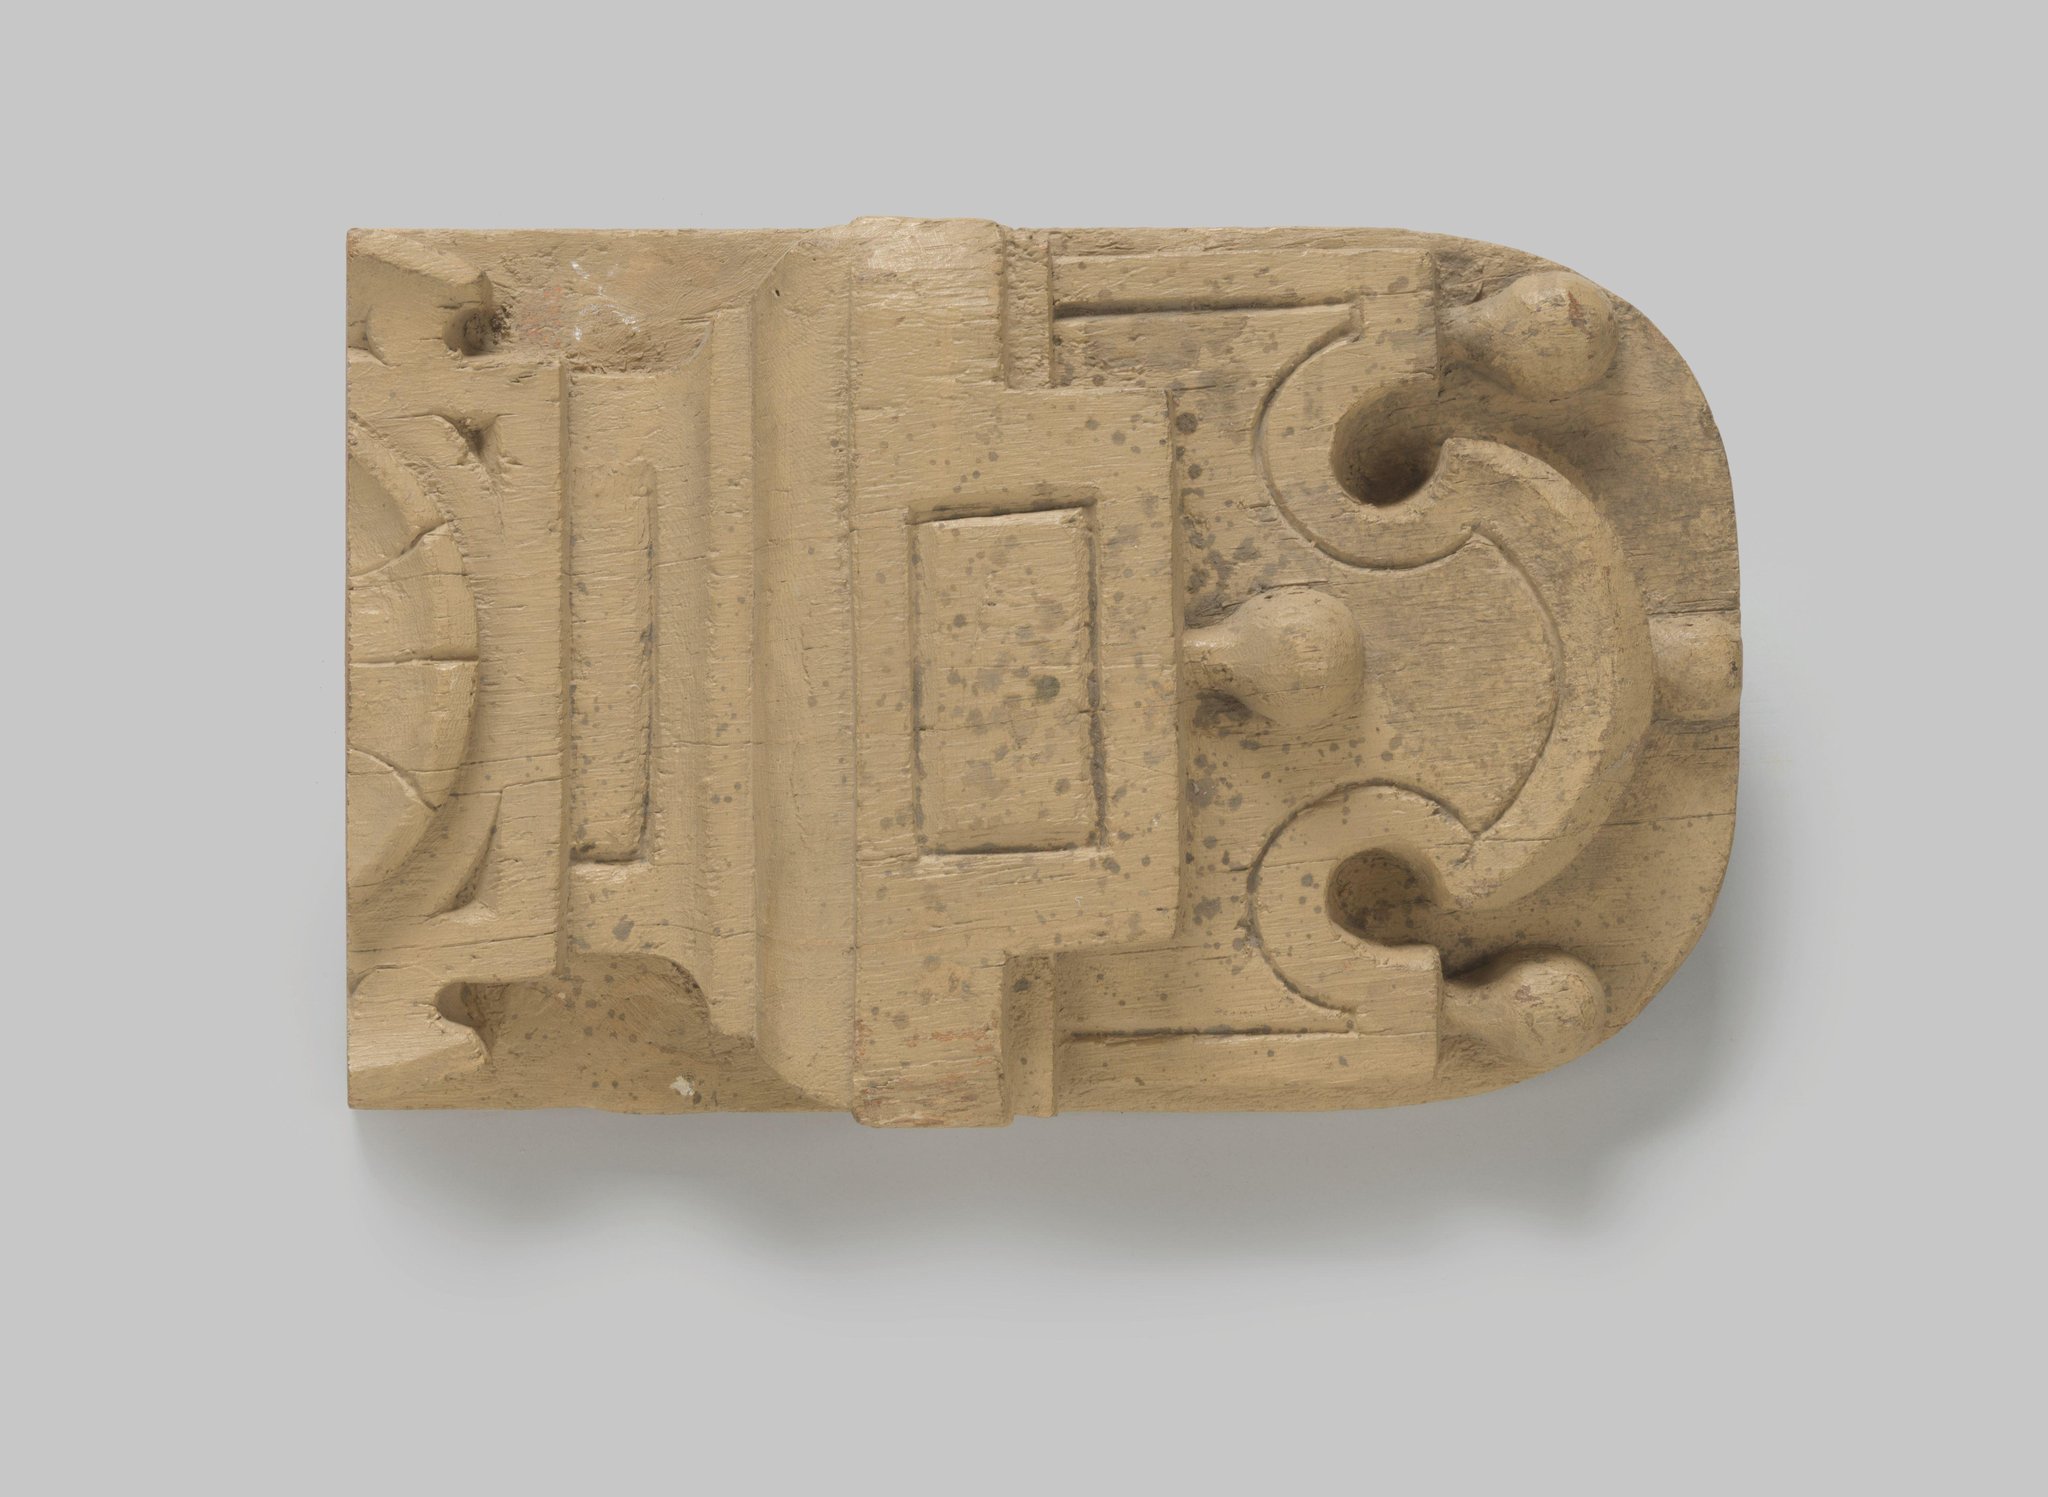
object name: stile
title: Gedeelte van een gebeeldhouwde stijl van eikenhout, afkomstig uit het z.g. Huis van Alva, Warmoestraat te Amsterdam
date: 1500-1699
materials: wood, paint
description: Gedeelte van gebeeldhouwde eikenhouten stijl (behorend bij BK-KOG-754-6), afkomstig uit het z.g. Huis van Alva, Warmoestraat te Amsterdam. In totaal gaat het om zes beschilderde stijlen (zie BK-KOG-754-1 t/m 6). Zie tevens BK-KOG-755-A t/m H, dit zijn twee kapitelen en zes stijlen van onbehandeld eikenhout die uit hetzelfde huis afkomstig zijn.